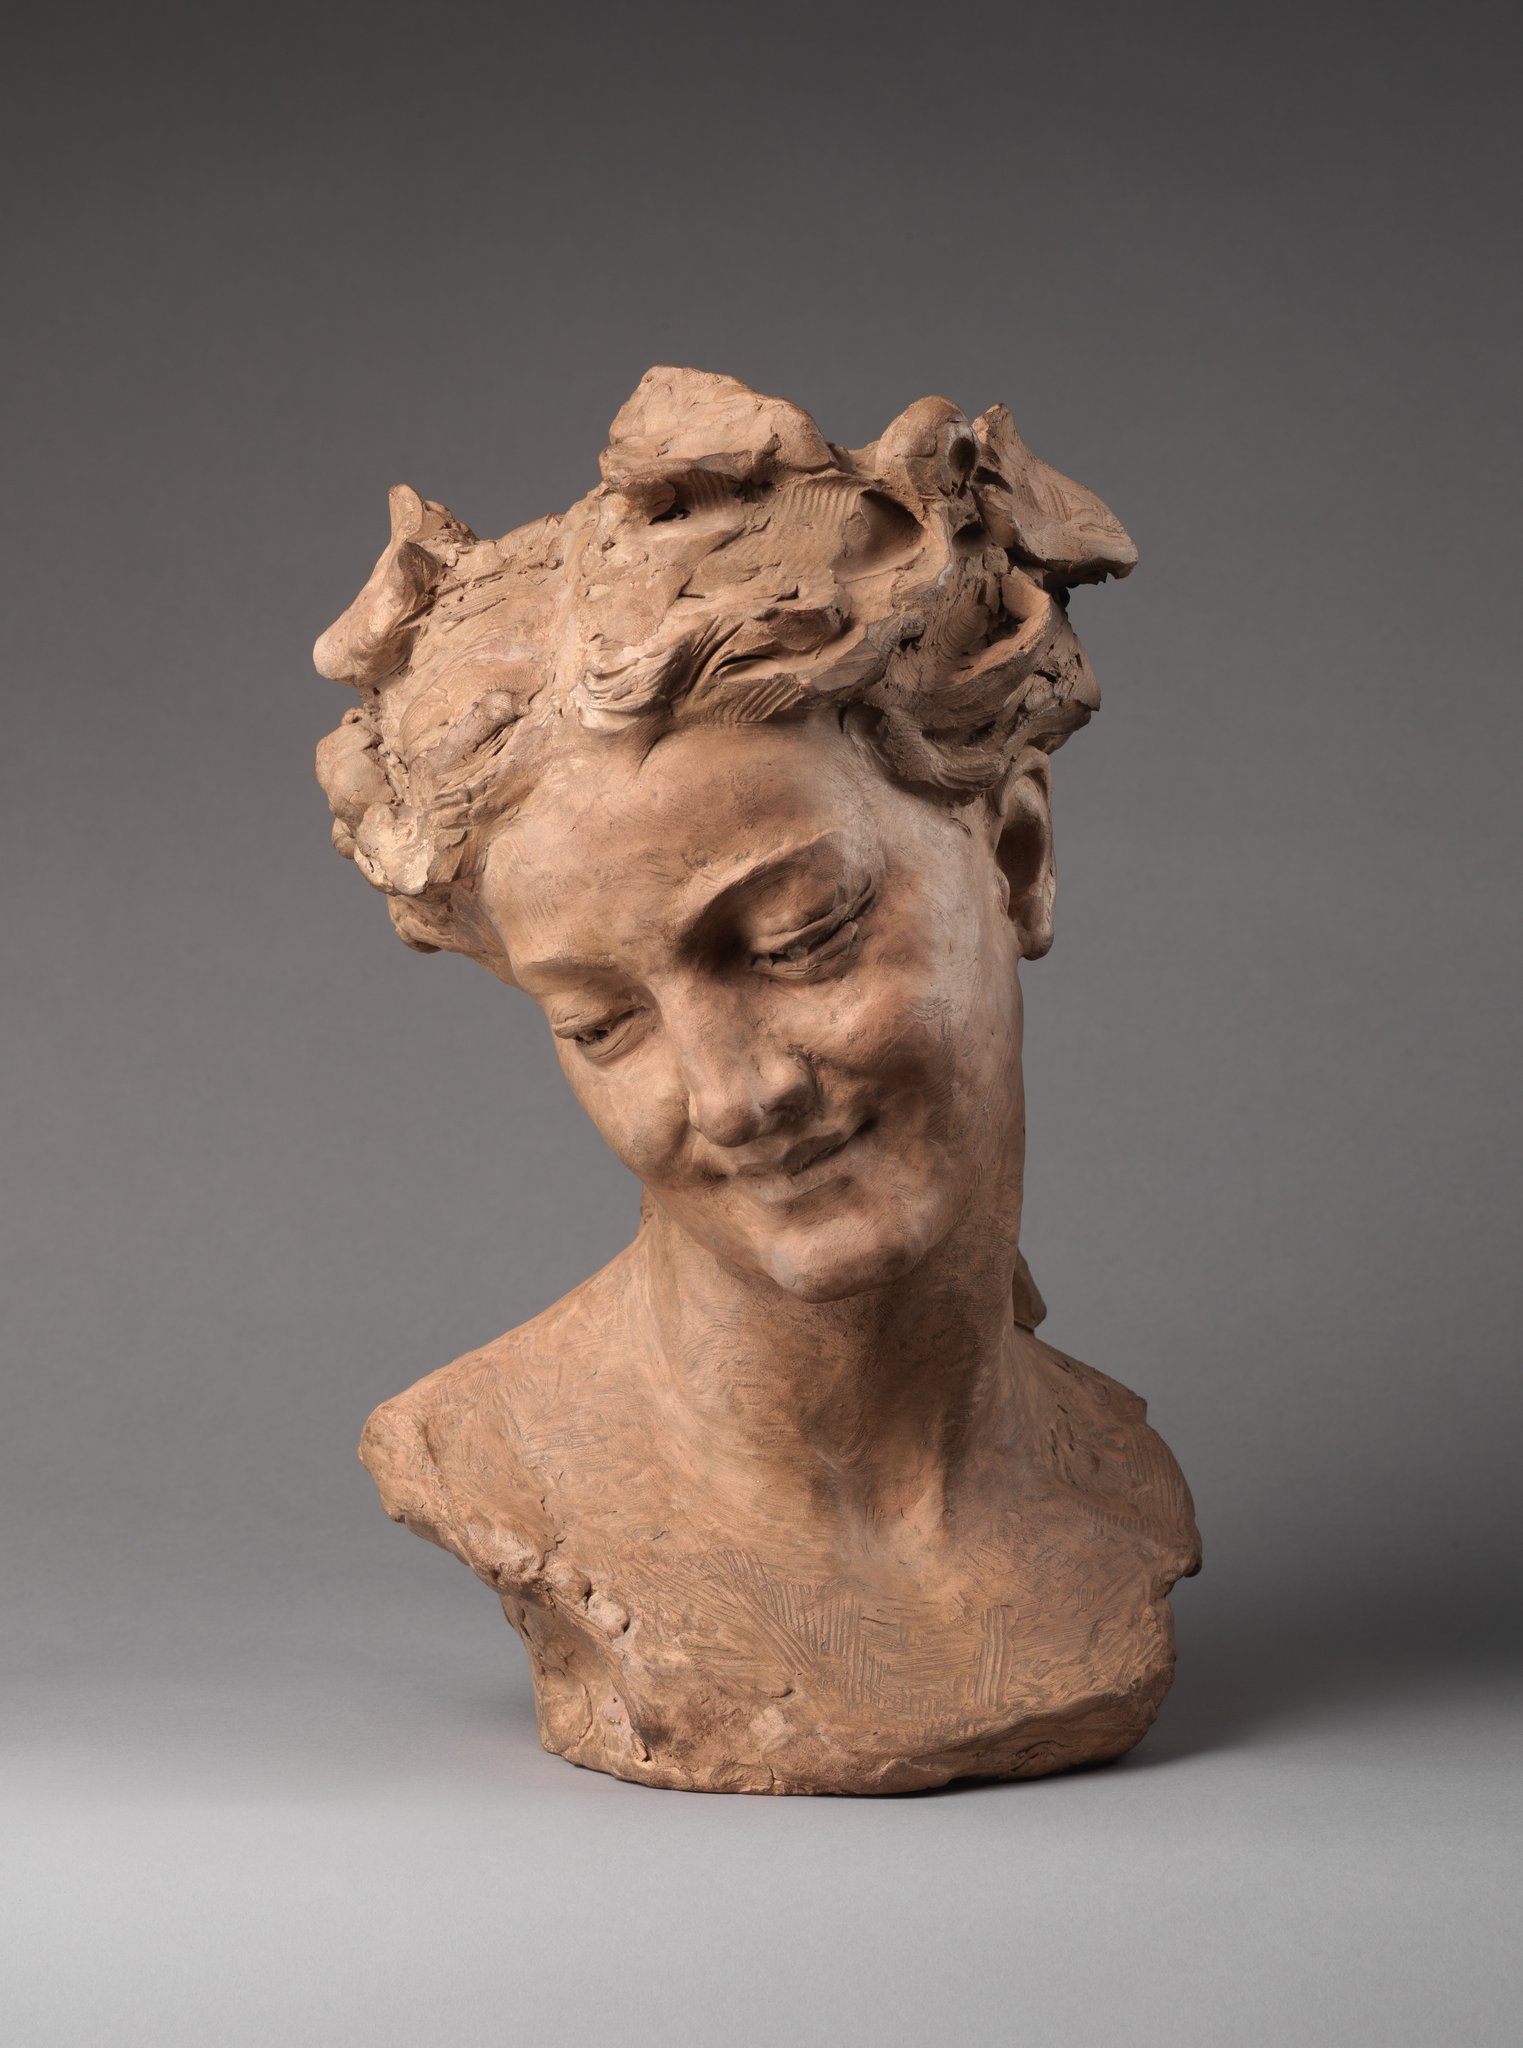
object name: bust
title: Bacchante with lowered eyes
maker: jean-baptiste carpeaux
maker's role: artist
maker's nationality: french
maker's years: 1827-1875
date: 1872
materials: terracotta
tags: women